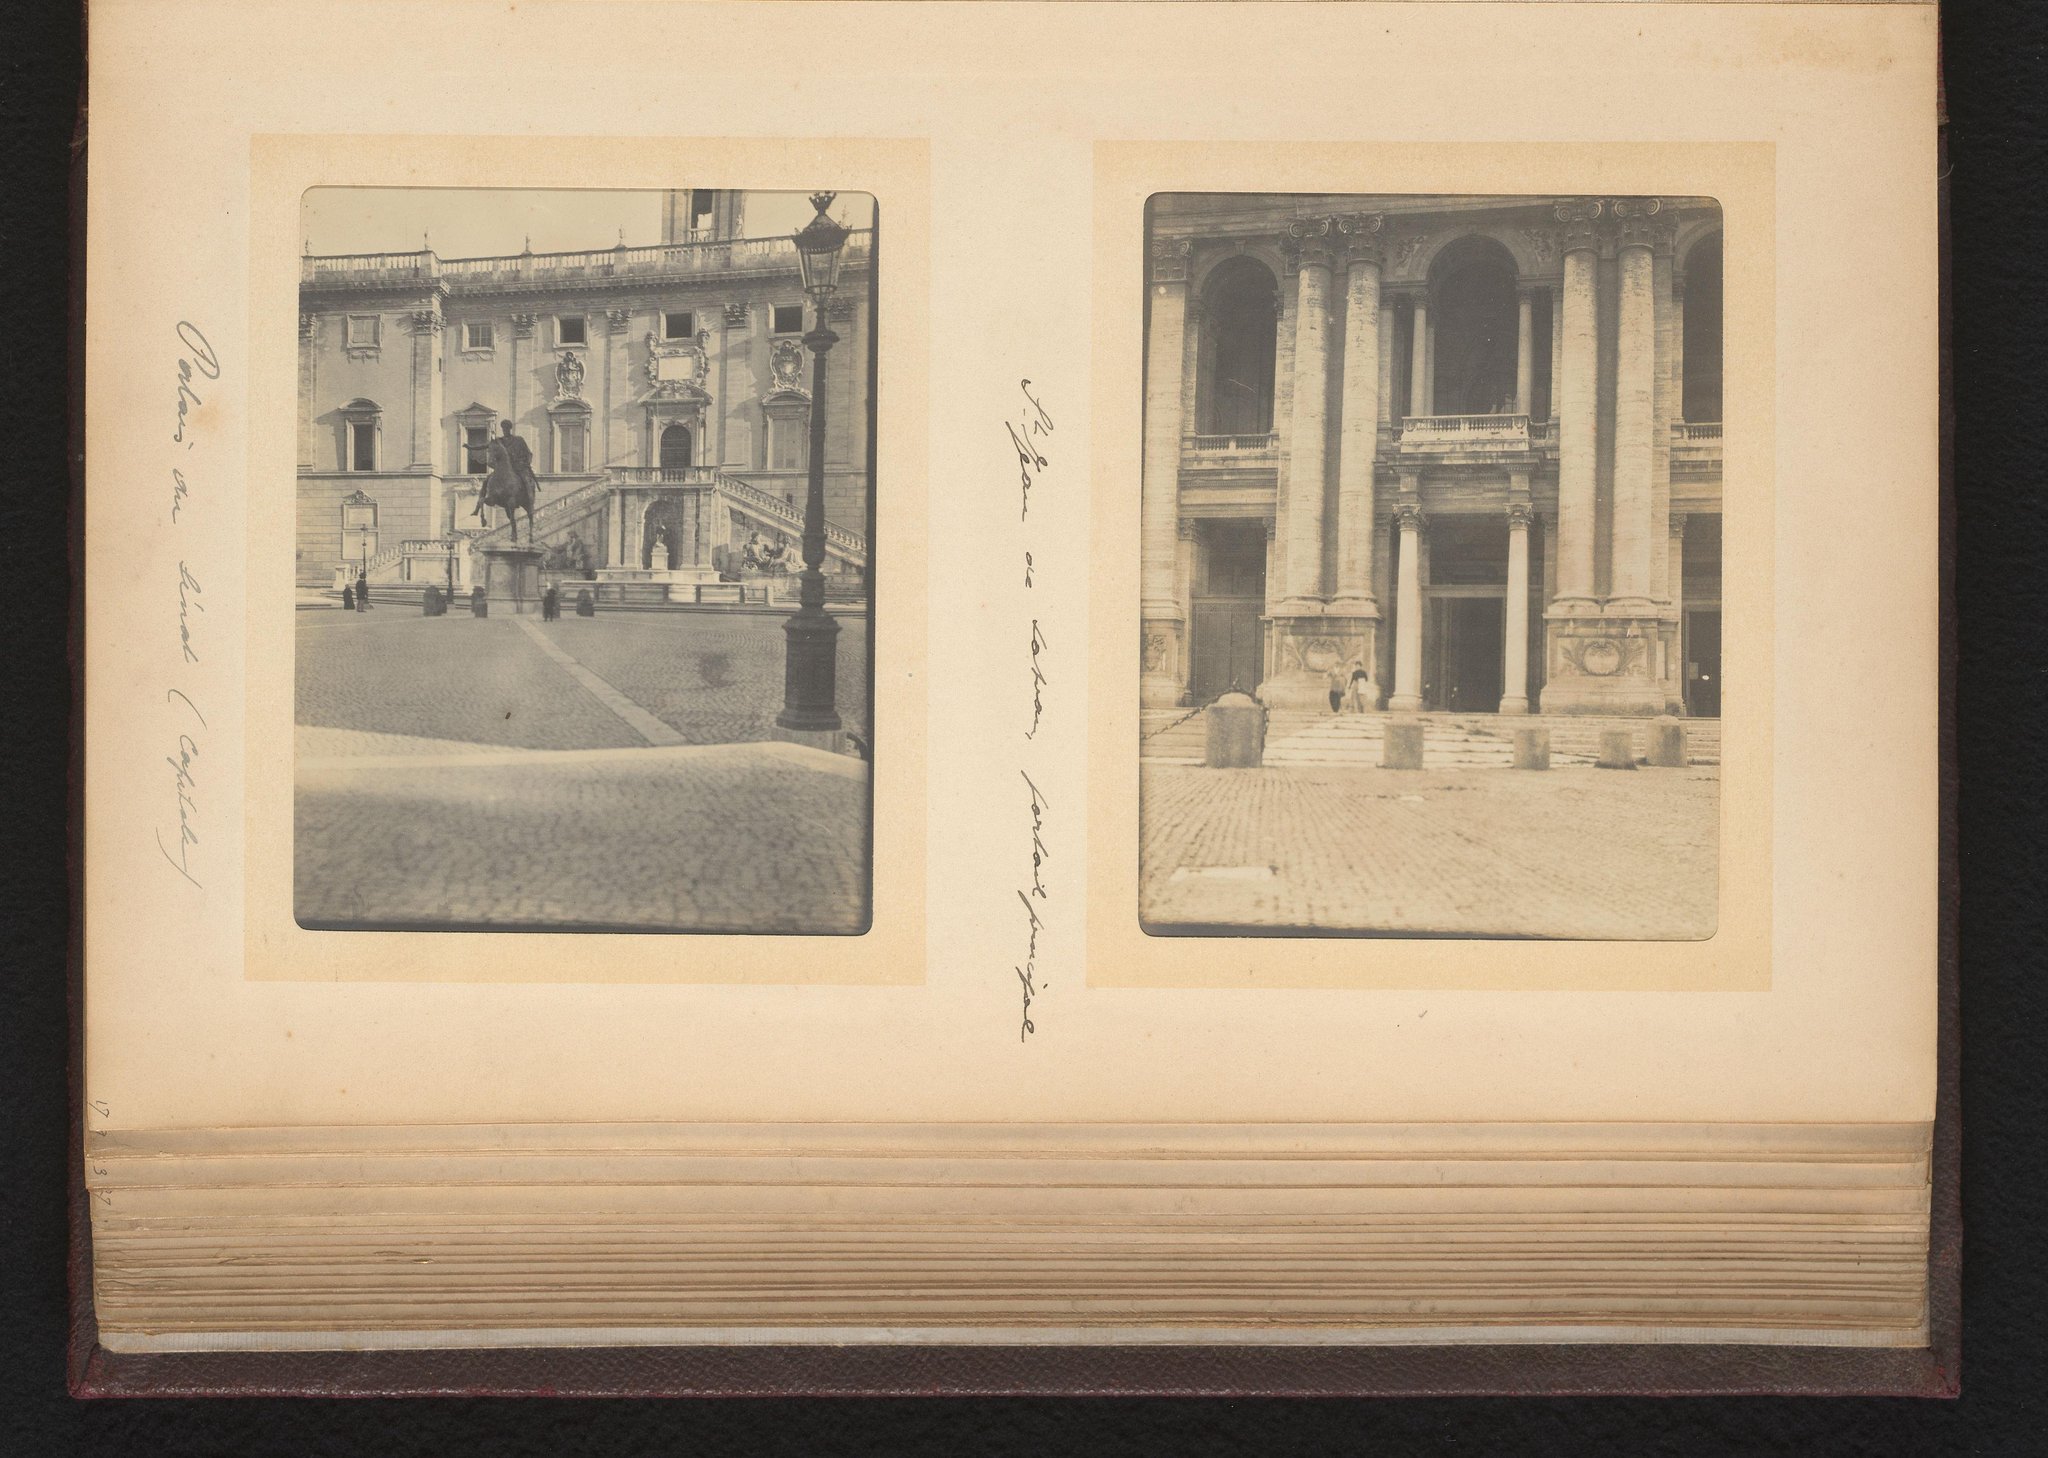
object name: album leaf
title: Klooster van de Sint-Jan van Lateranen en een gezicht over de stad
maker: Anonymous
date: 1895-1905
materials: cardboard, photographic support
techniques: gelatin silver print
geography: rome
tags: tourism, church (exterior), cloisters ~ monastery, prospect of city, town panorama, silhouette of city, rome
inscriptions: inscription: ‘Cloistre de St Jean de Latran / Rome vue de Janicule’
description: Albumblad met twee foto's in Rome. Onderdeel van een fotoalbum van een reis door Italië, ca. 1900.